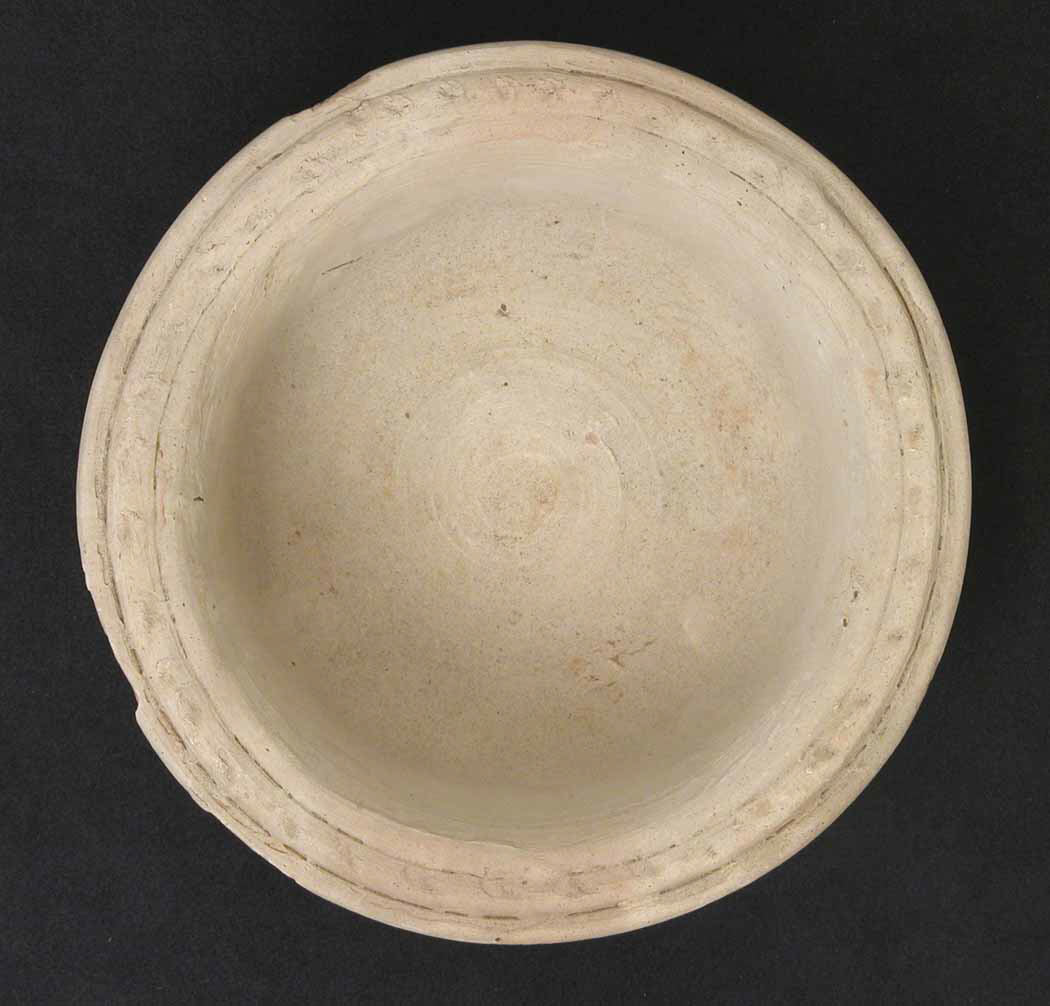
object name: dish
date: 801-1100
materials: earthenware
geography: iran